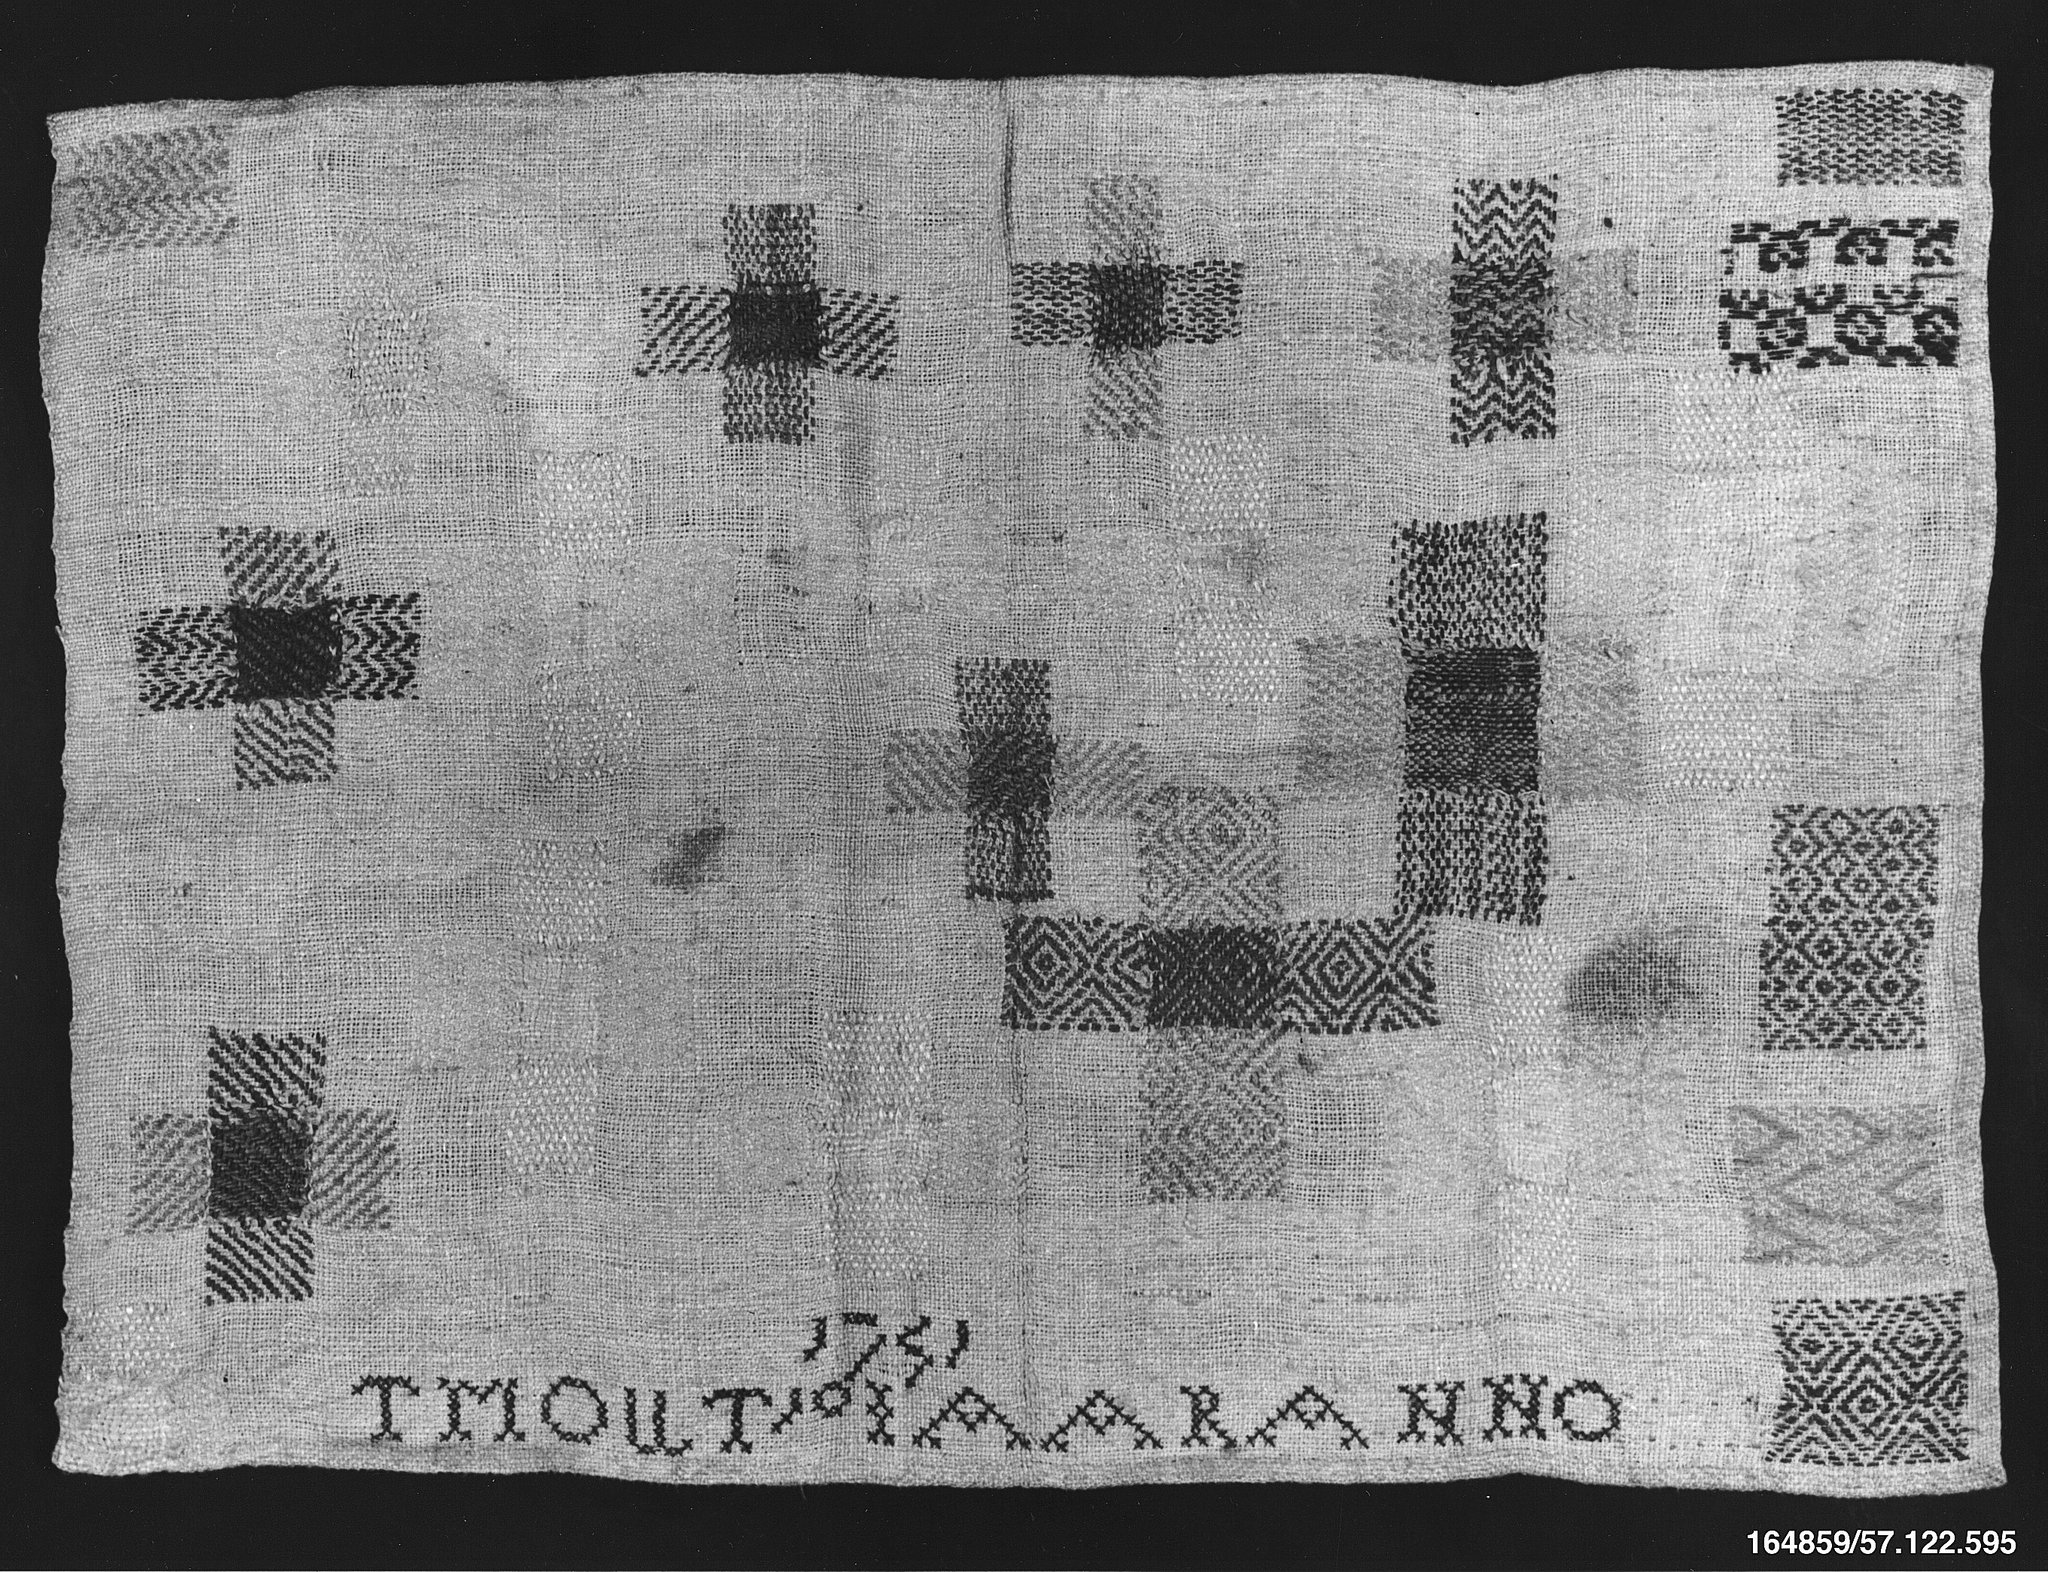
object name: sampler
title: Embroidered darning sampler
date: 1751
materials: linen